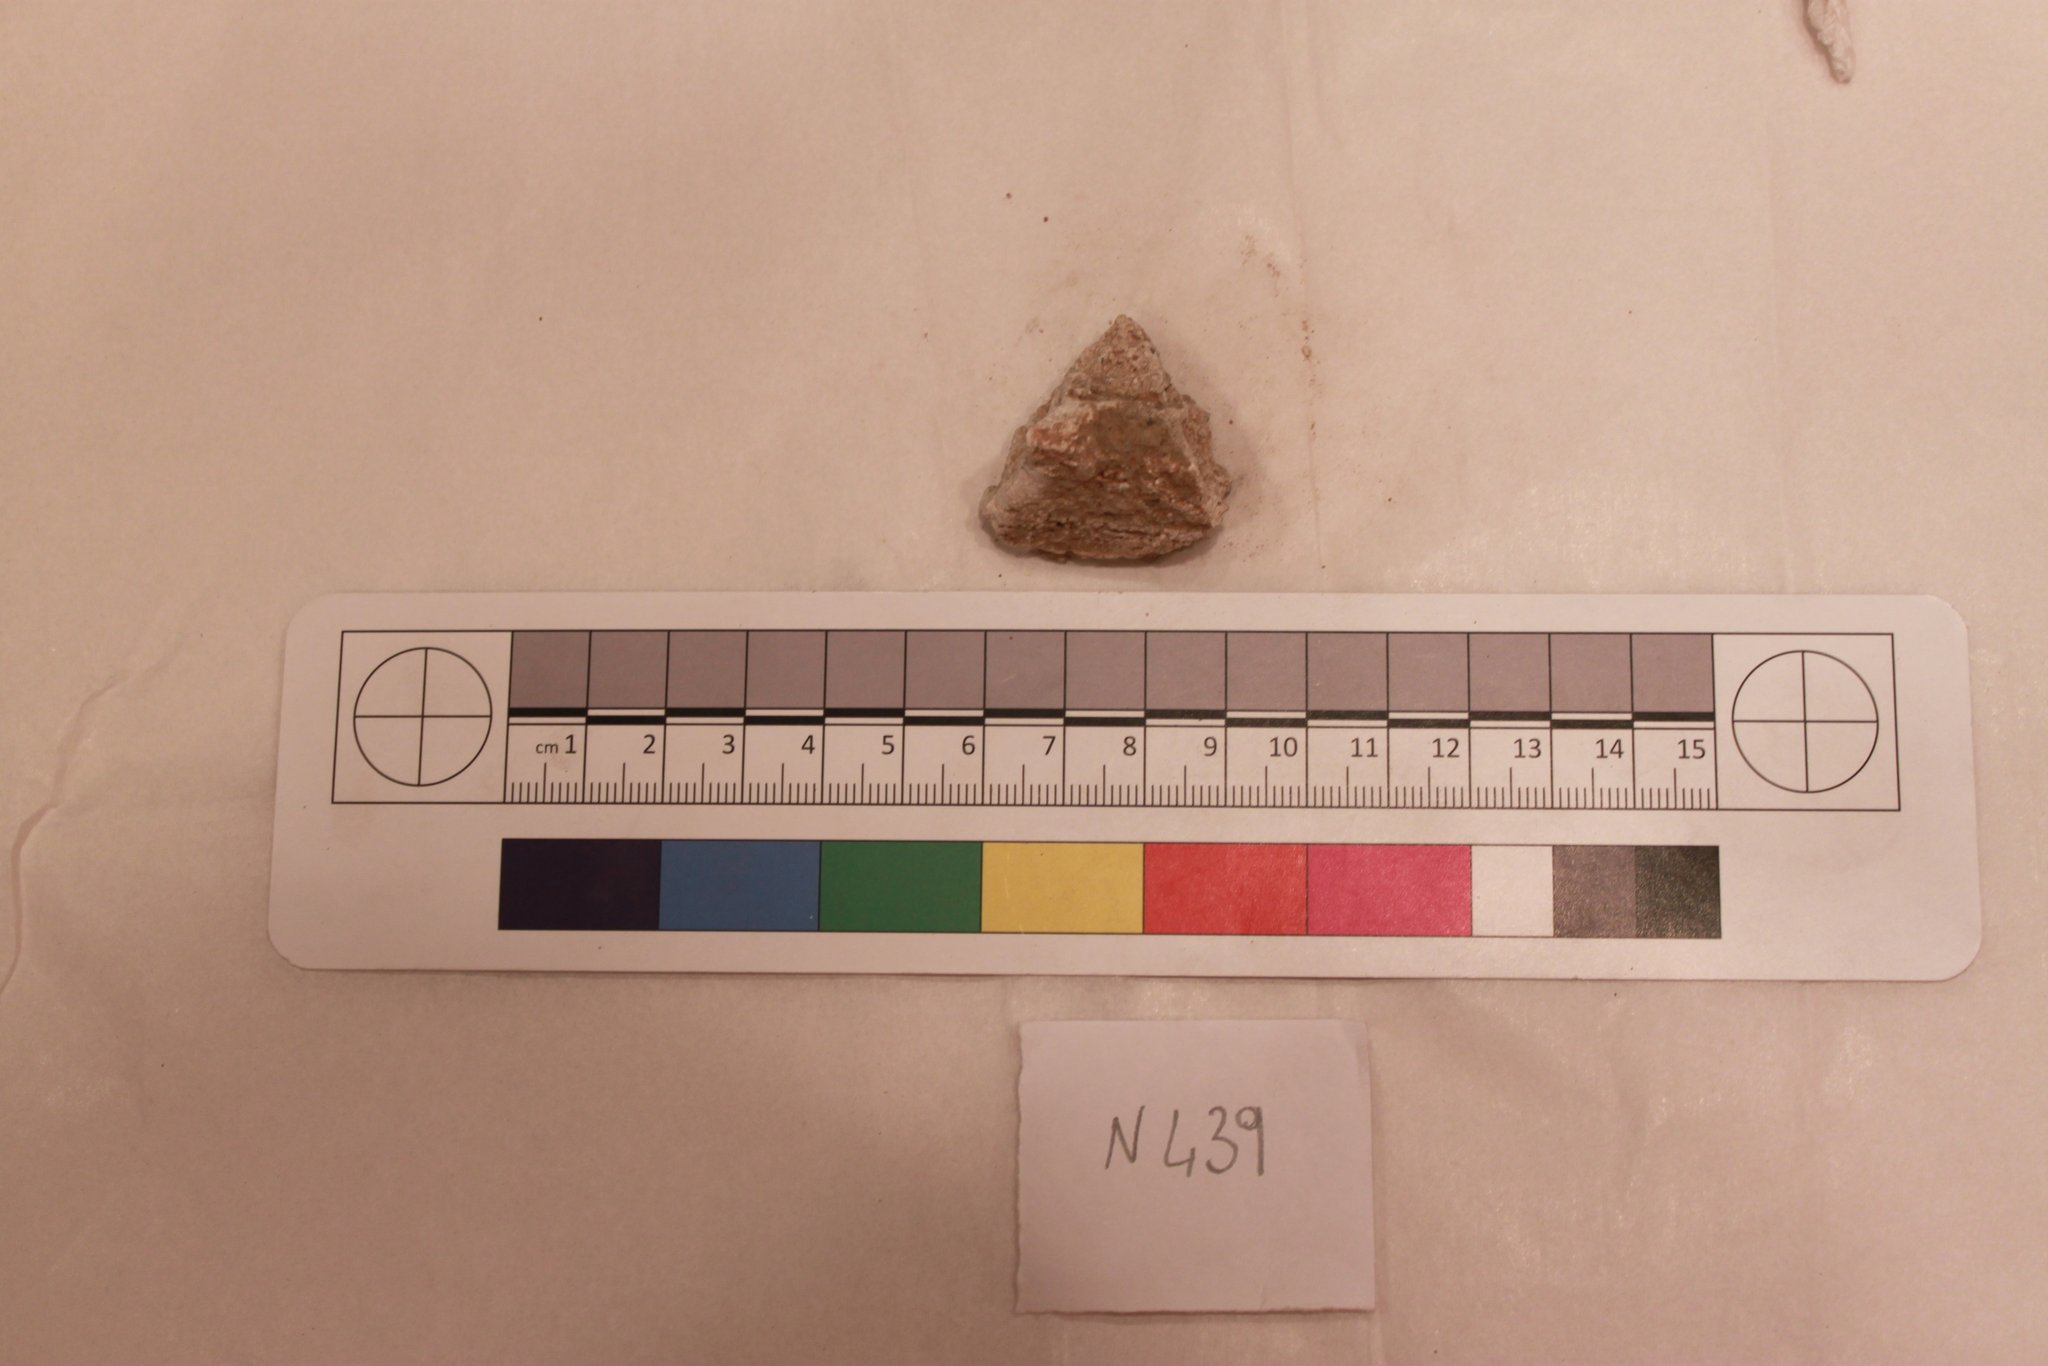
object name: fragment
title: Stucco Fragment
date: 701-1200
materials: plaster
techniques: carving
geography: iran